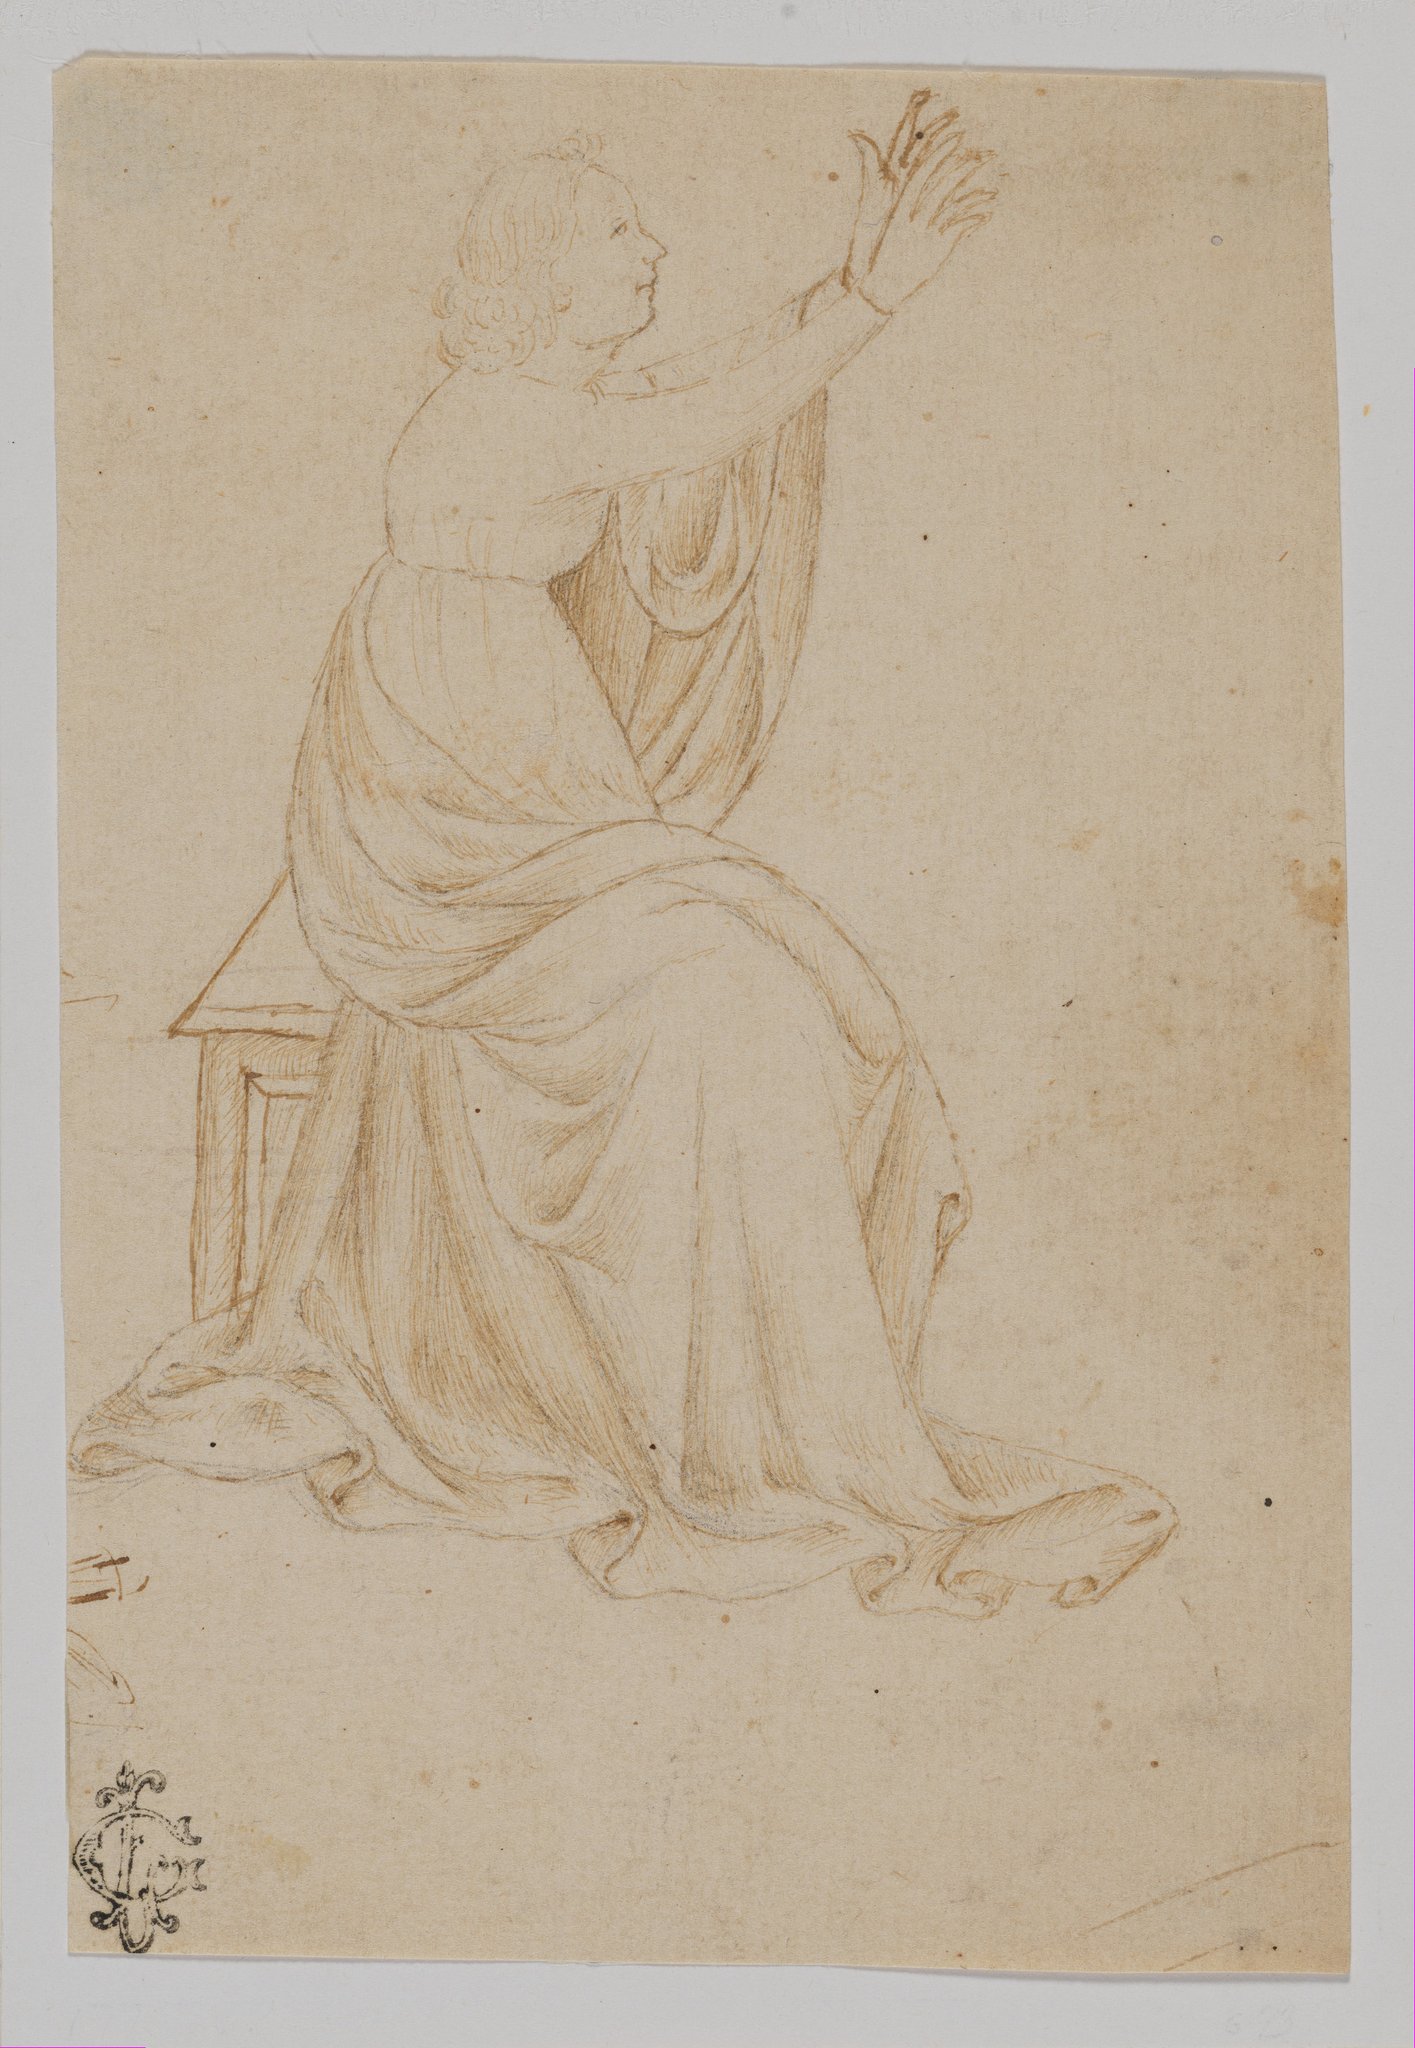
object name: drawing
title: Seated Female Figure with Upraised Arms, Facing Right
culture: italian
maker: veronese school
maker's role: artist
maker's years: 1430-1469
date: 1434-1466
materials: chalk, ink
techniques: pen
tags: women